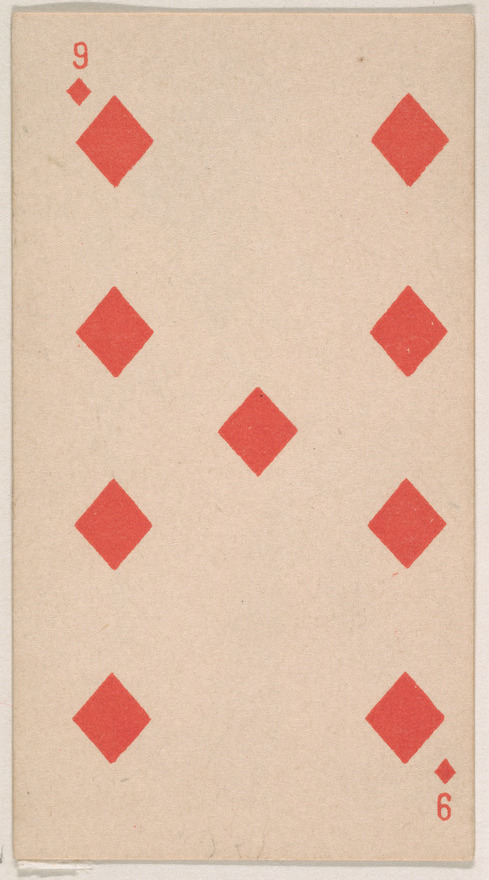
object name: print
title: Nine of Diamonds, from the Transparent Playing Cards series (N220) issued by Kinney Bros.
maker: kinney brothers tobacco company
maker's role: publisher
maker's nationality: american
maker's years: 1869-2011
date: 1888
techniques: color lithograph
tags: playing cards